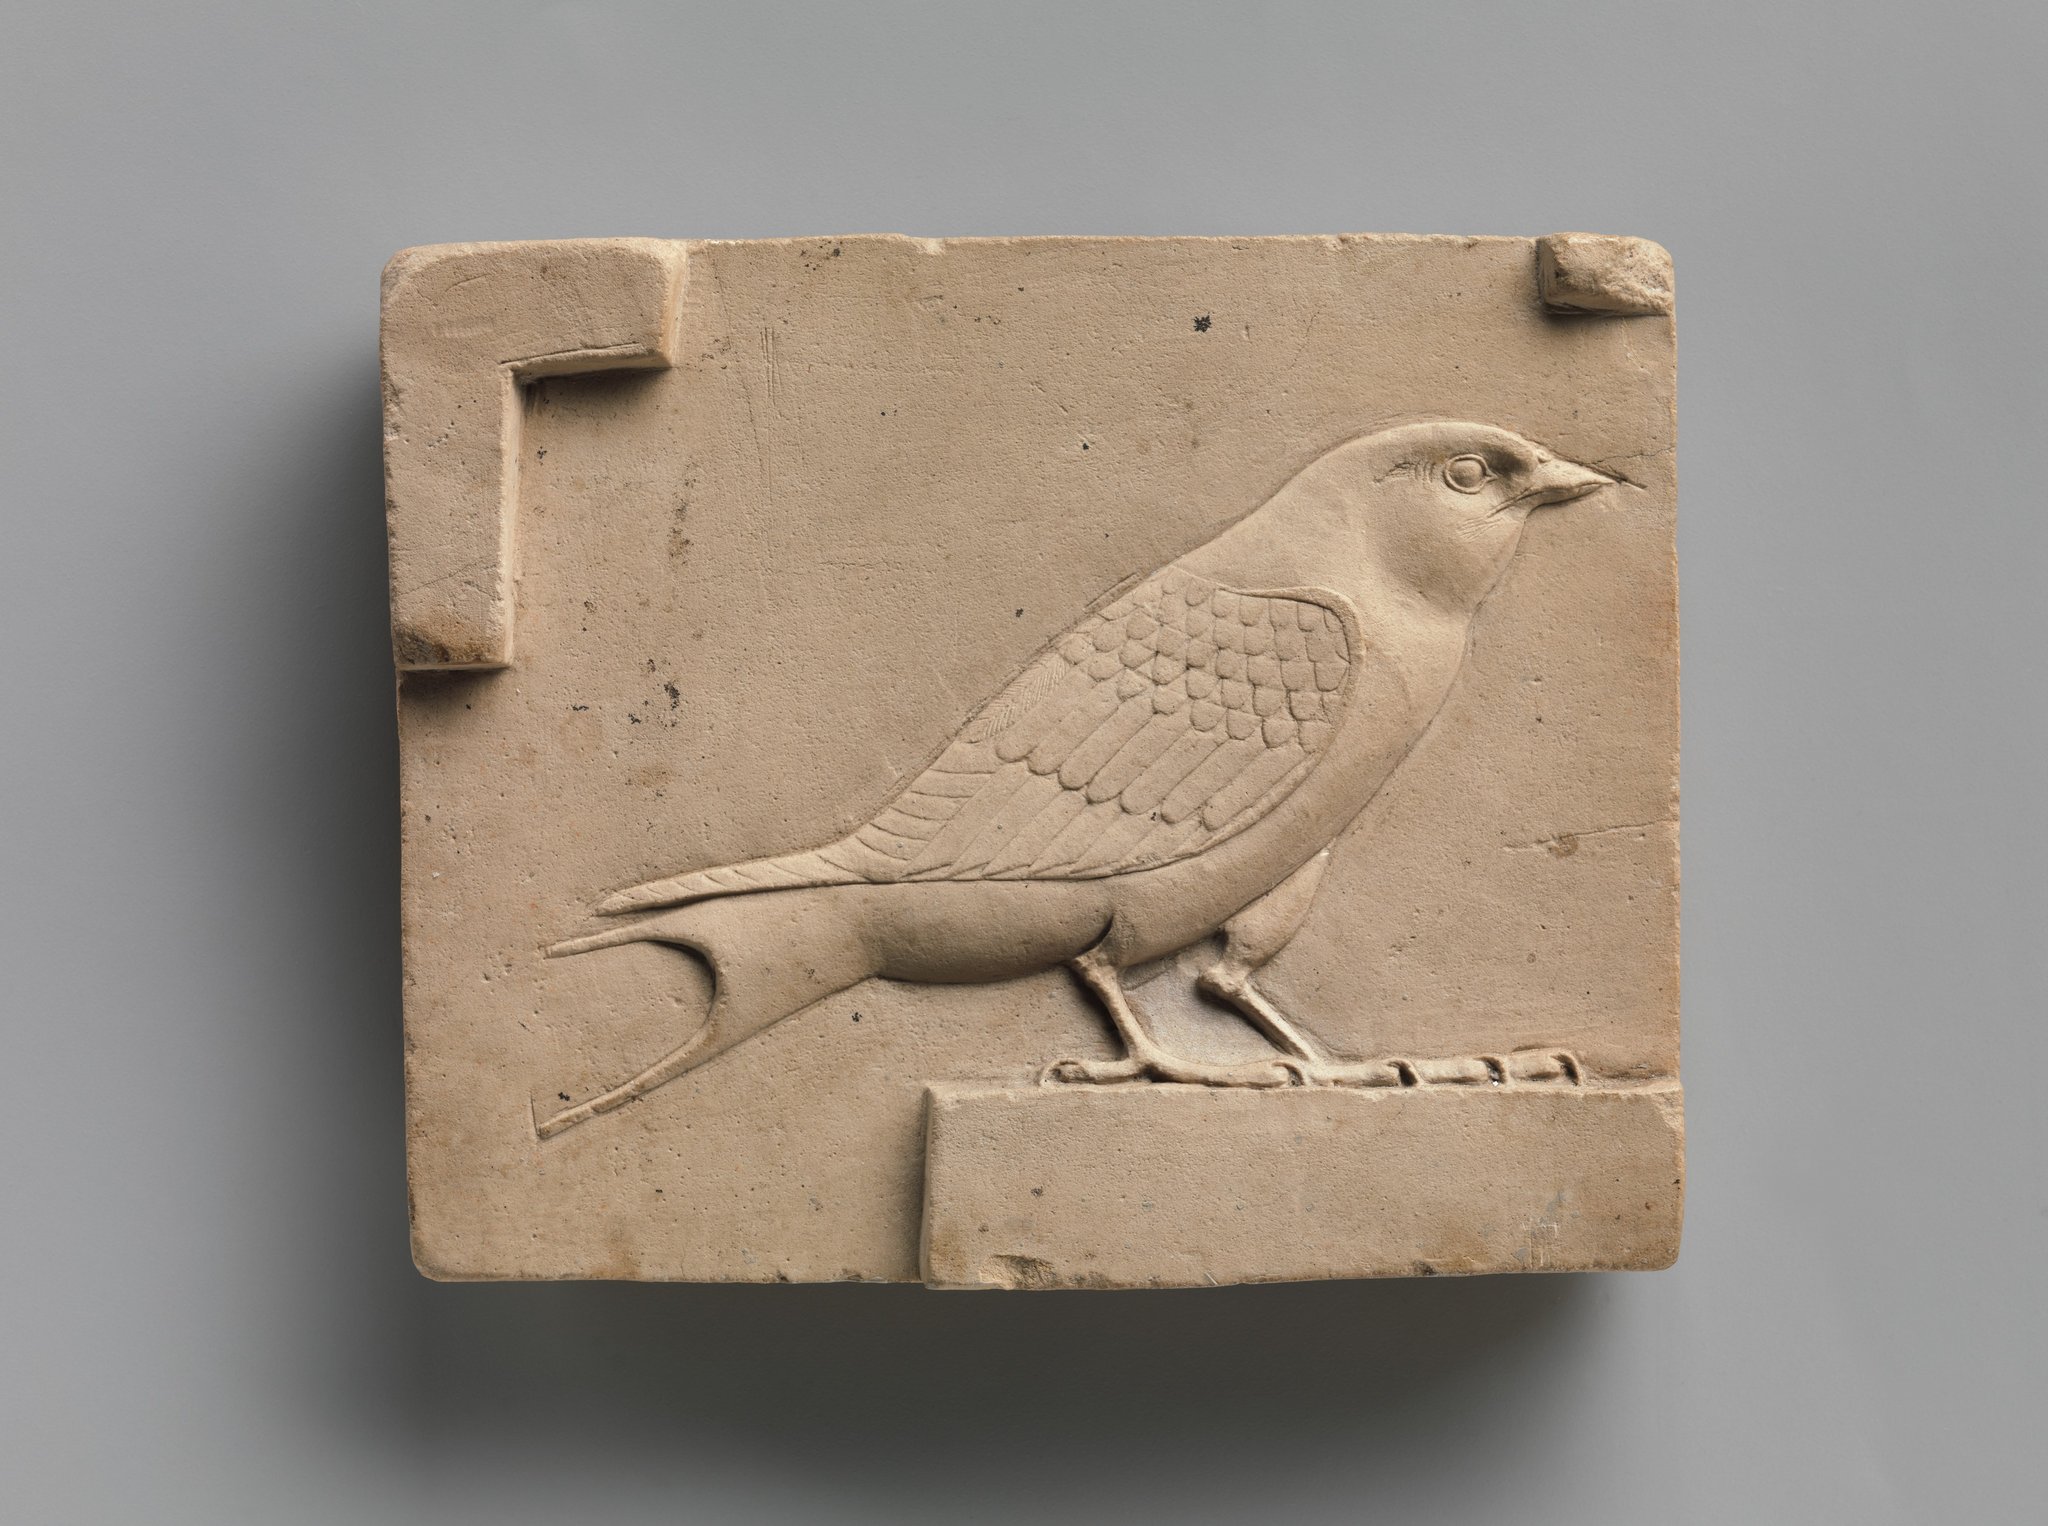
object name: sculptor's model votive, swallow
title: Relief plaque with a swallow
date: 400-30 BCE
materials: limestone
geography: egypt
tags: birds